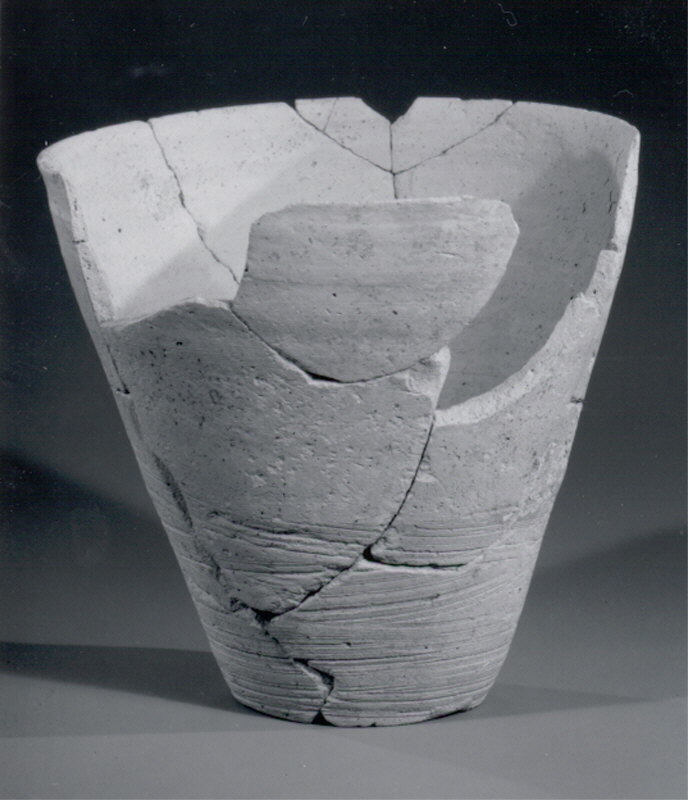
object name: beaker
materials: ceramic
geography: mesopotamia